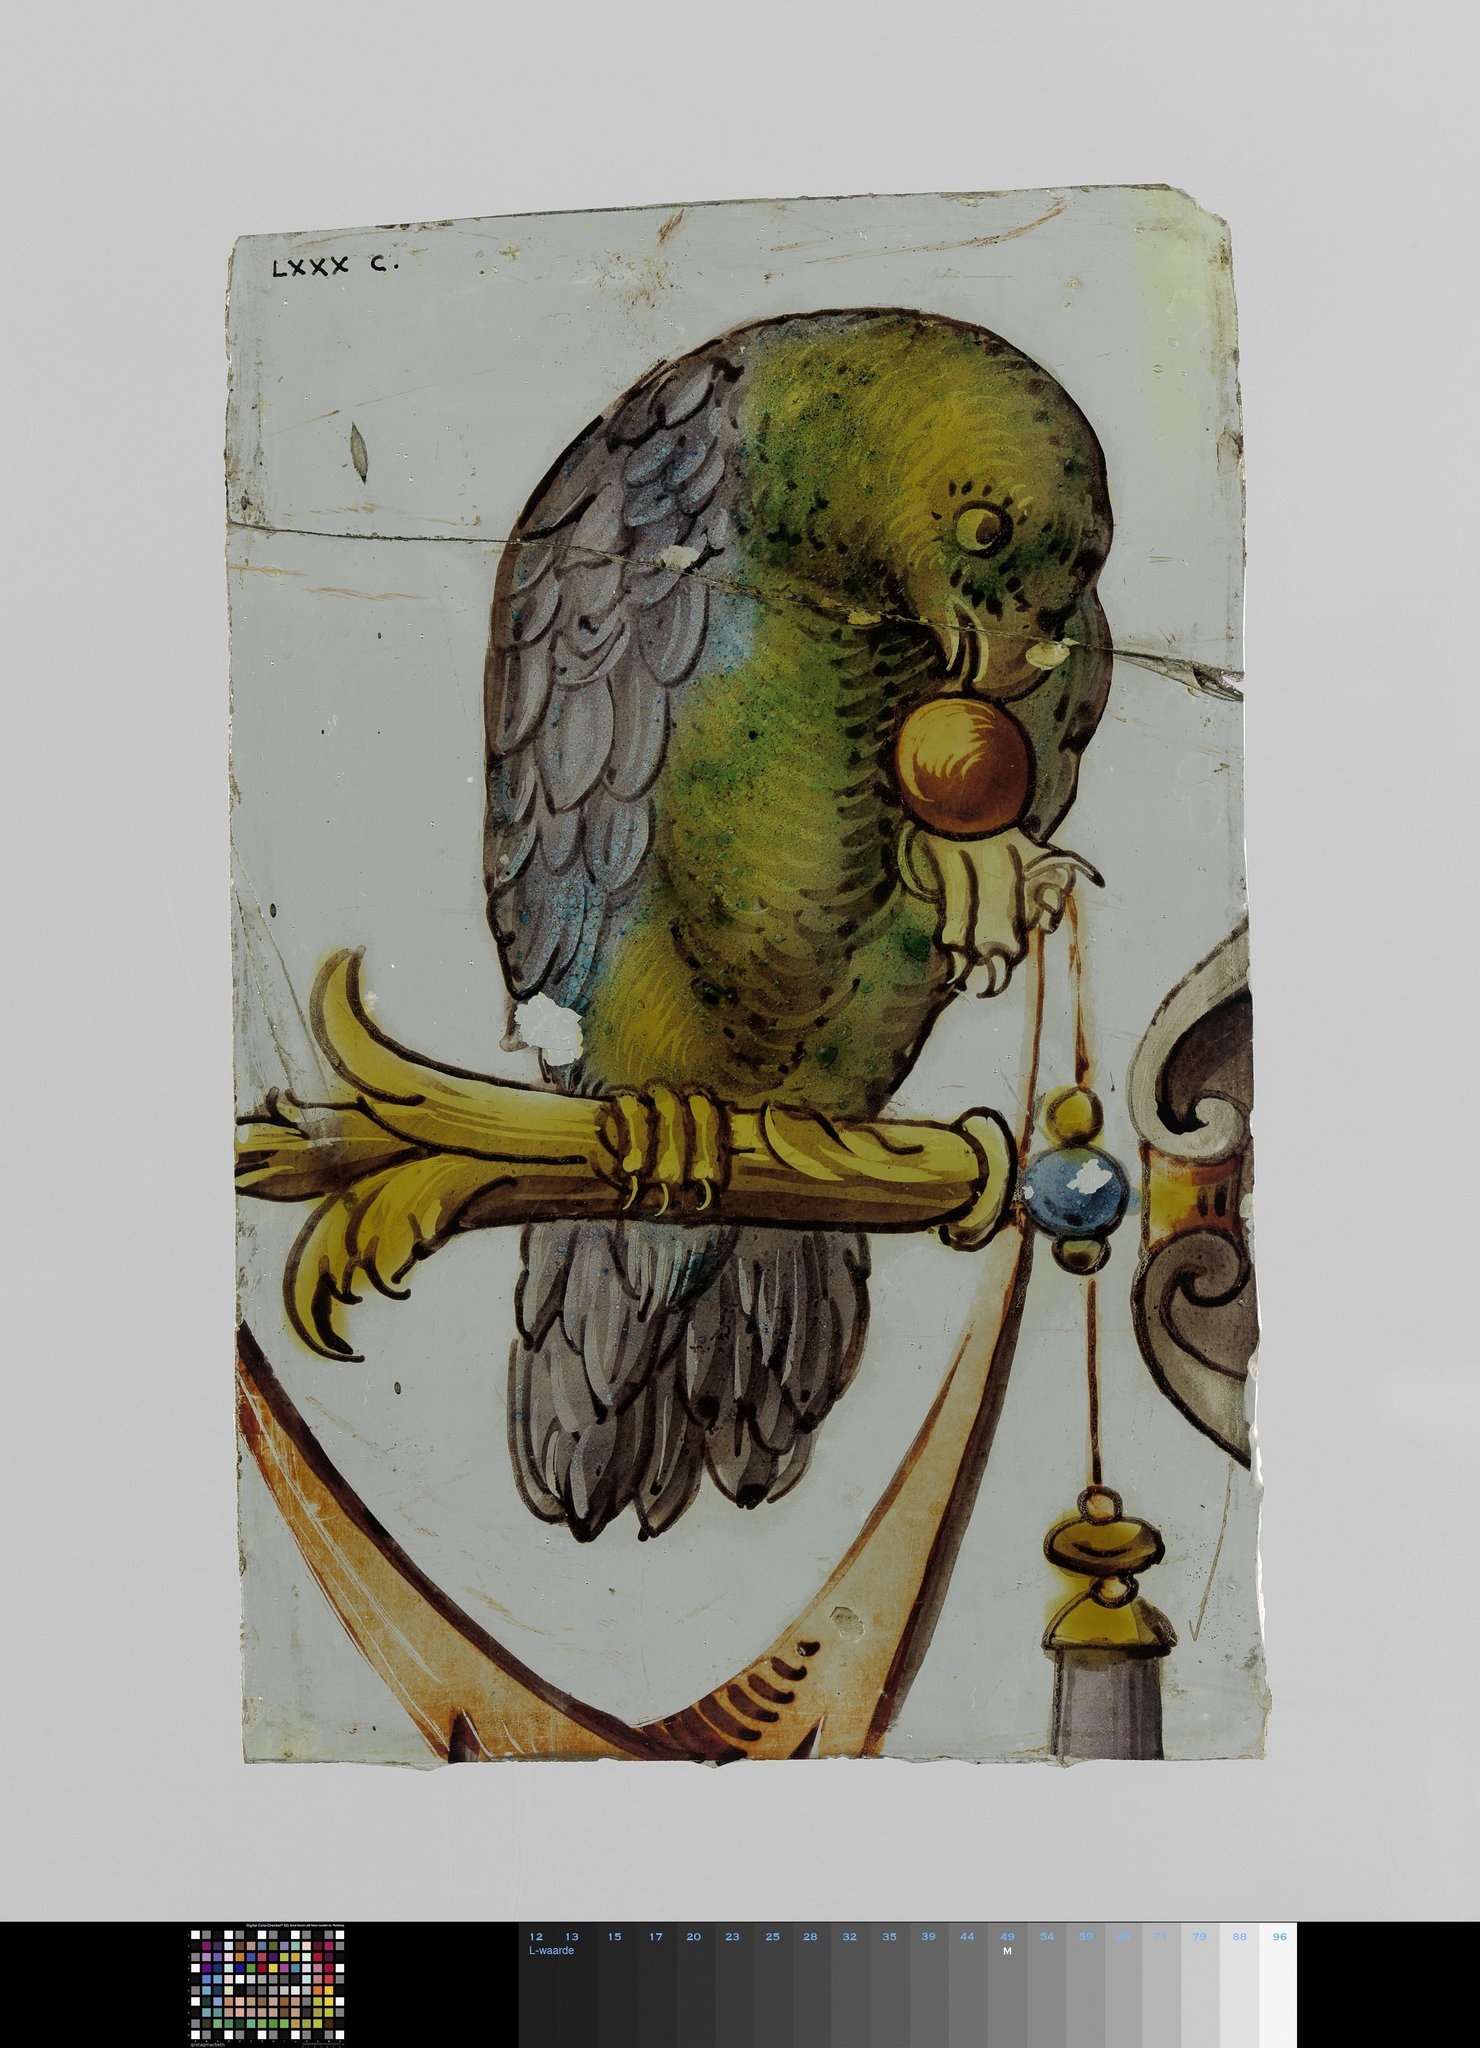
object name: light window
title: Ruit met een vogel met kers in zijn snavel en een festoen aan een poot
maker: Anonymous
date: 1650-1675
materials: glass, lead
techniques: enamel painting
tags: birds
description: Een ruit met emailschildering van een vogel met in zijn snavel een kers en een festoen aan één der poten.